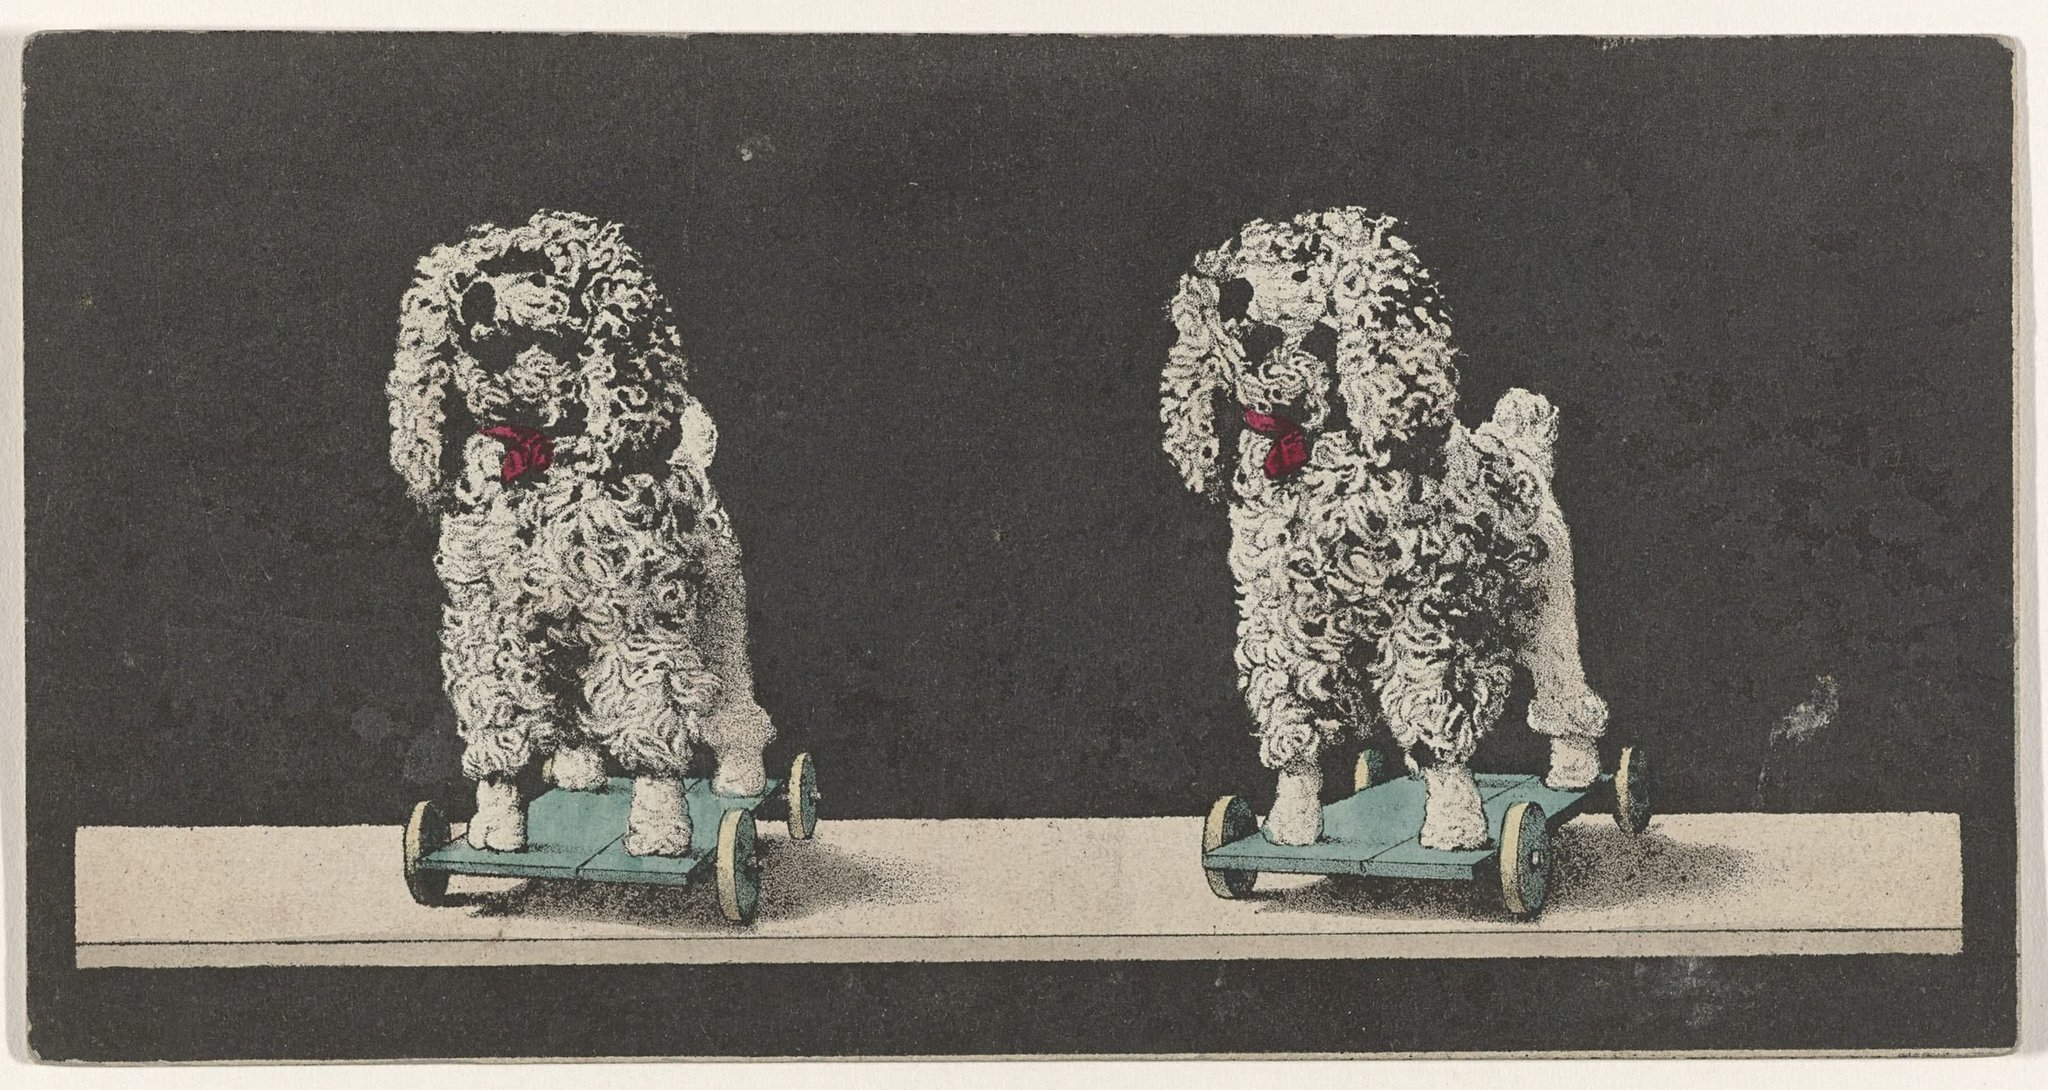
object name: print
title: Speelgoedhond op wielen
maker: Anonymous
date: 1850-1900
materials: paper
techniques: hand coloring, lithograph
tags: (playing with) dolls, toy animals